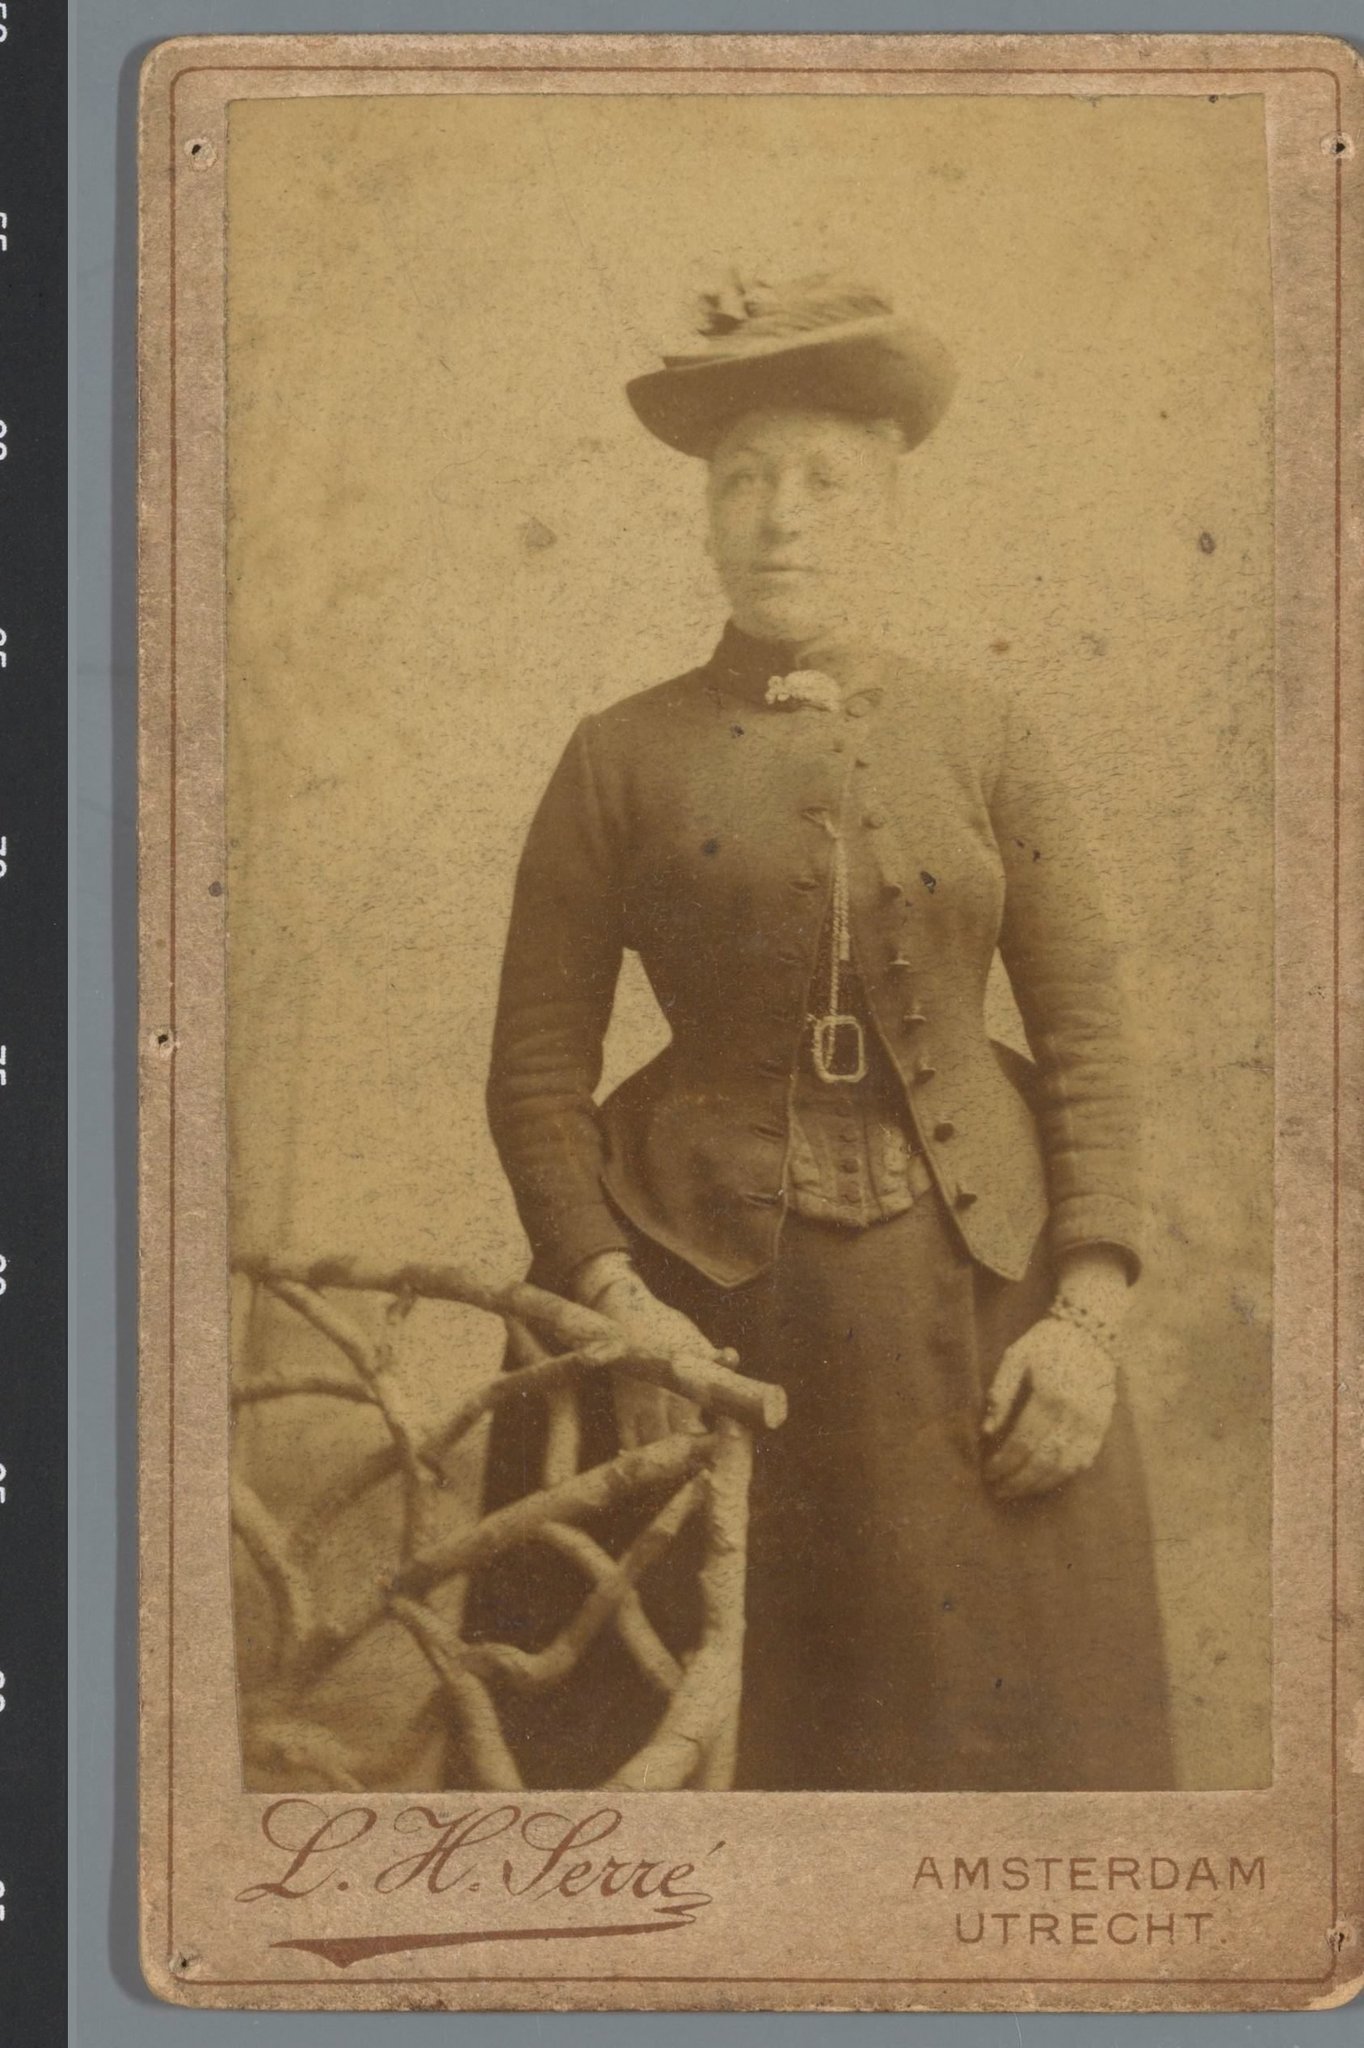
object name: carte de visite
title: Portret van een onbekende vrouw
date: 1877-1897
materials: cardboard, paper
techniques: albumen print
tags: historical persons - bb - woman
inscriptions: inscription: ‘AMSTERDAM/ Damstraat 34/ L. H. Serré/ UTRECHT./ Nachtegaalstraat 29./ Voor nabestelling wordt de origineele plaat/ bewaard./ Vergrooting naar alle bestaande Photographien.’